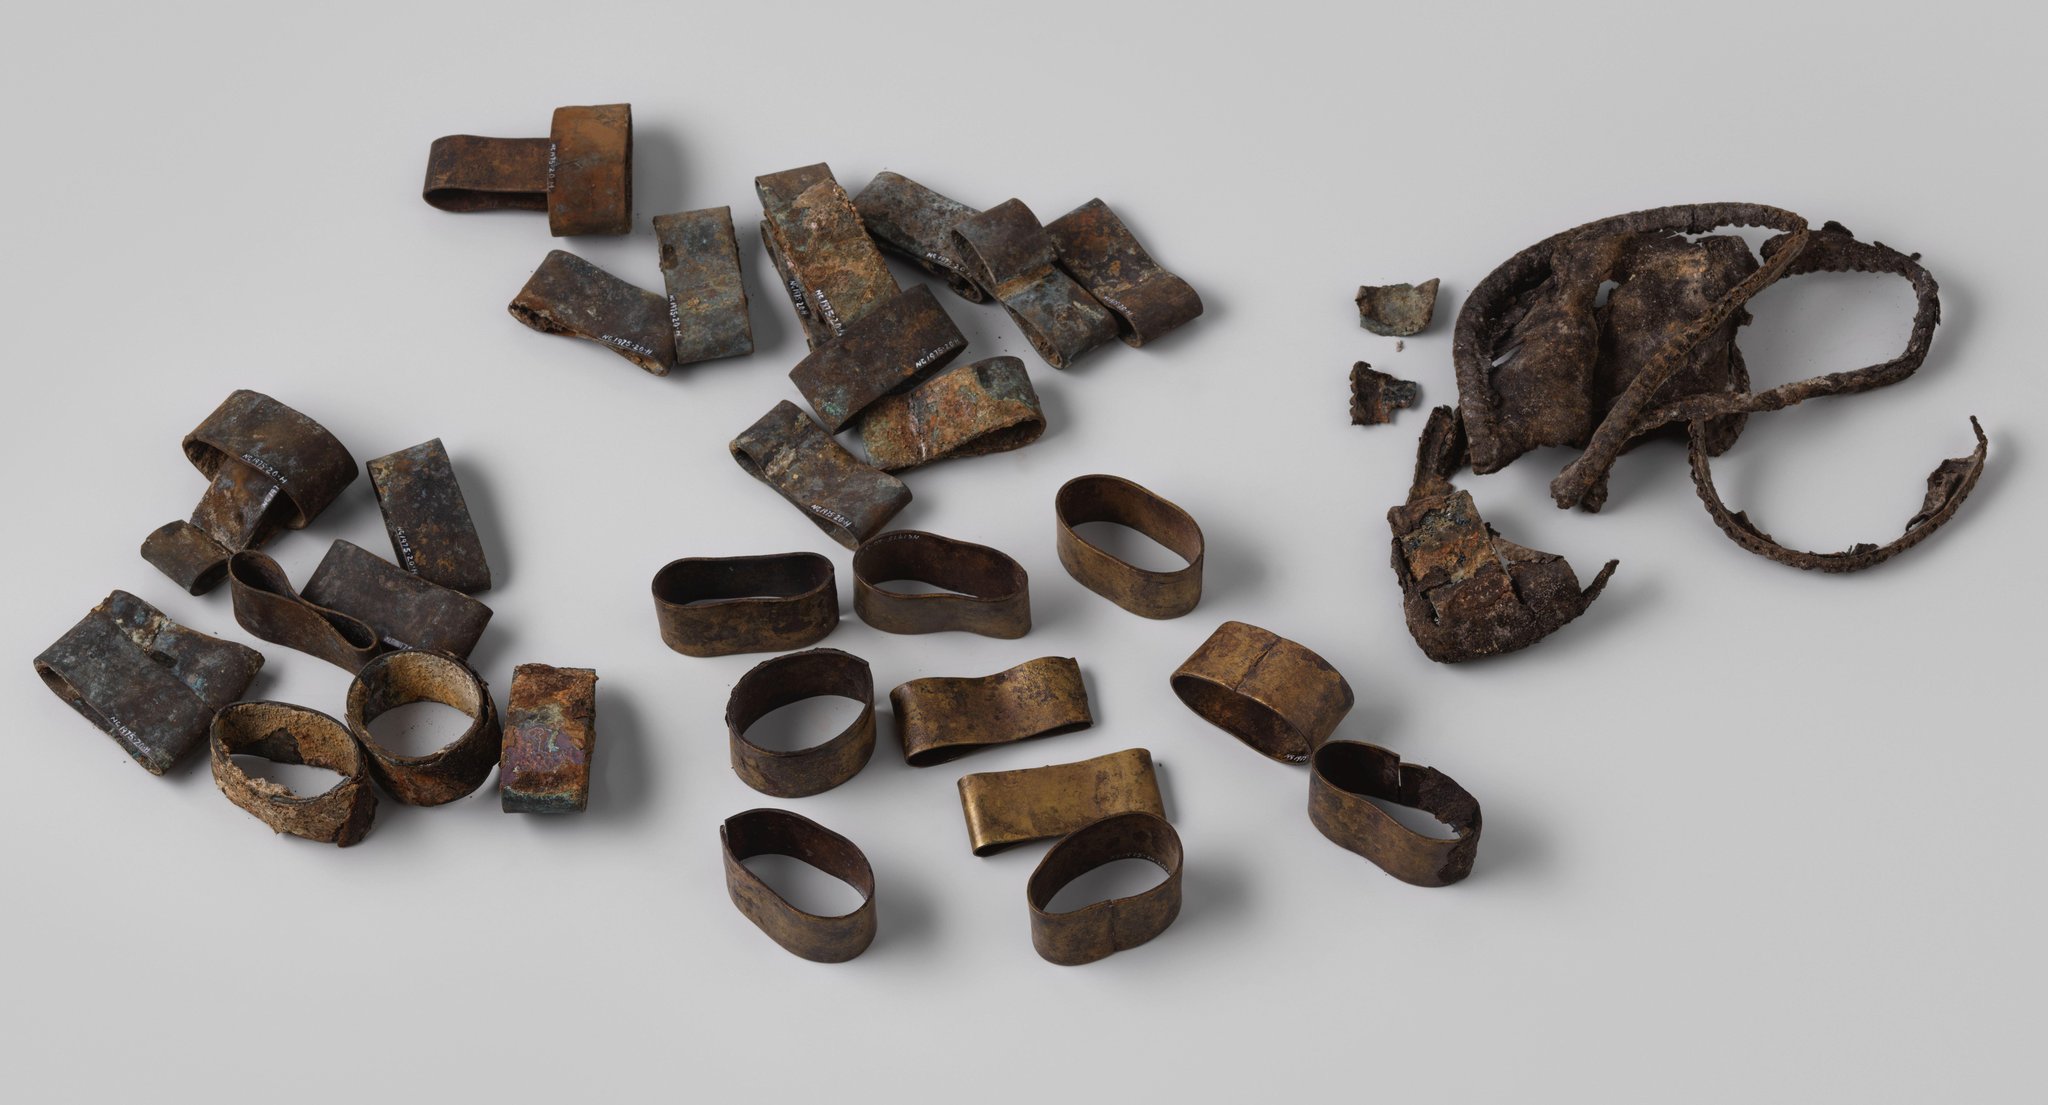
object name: firehose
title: Brandslangringen uit het wrak van de Oost-Indiëvaarder Hollandia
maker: Anonymous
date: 1700-1743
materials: copper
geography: netherlands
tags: verenigde oostindische compagnie, hollandia (schip), annet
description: Fire engine, firehose; fragm: rings, partly squashed, some fragm of (le) hose, firehose.